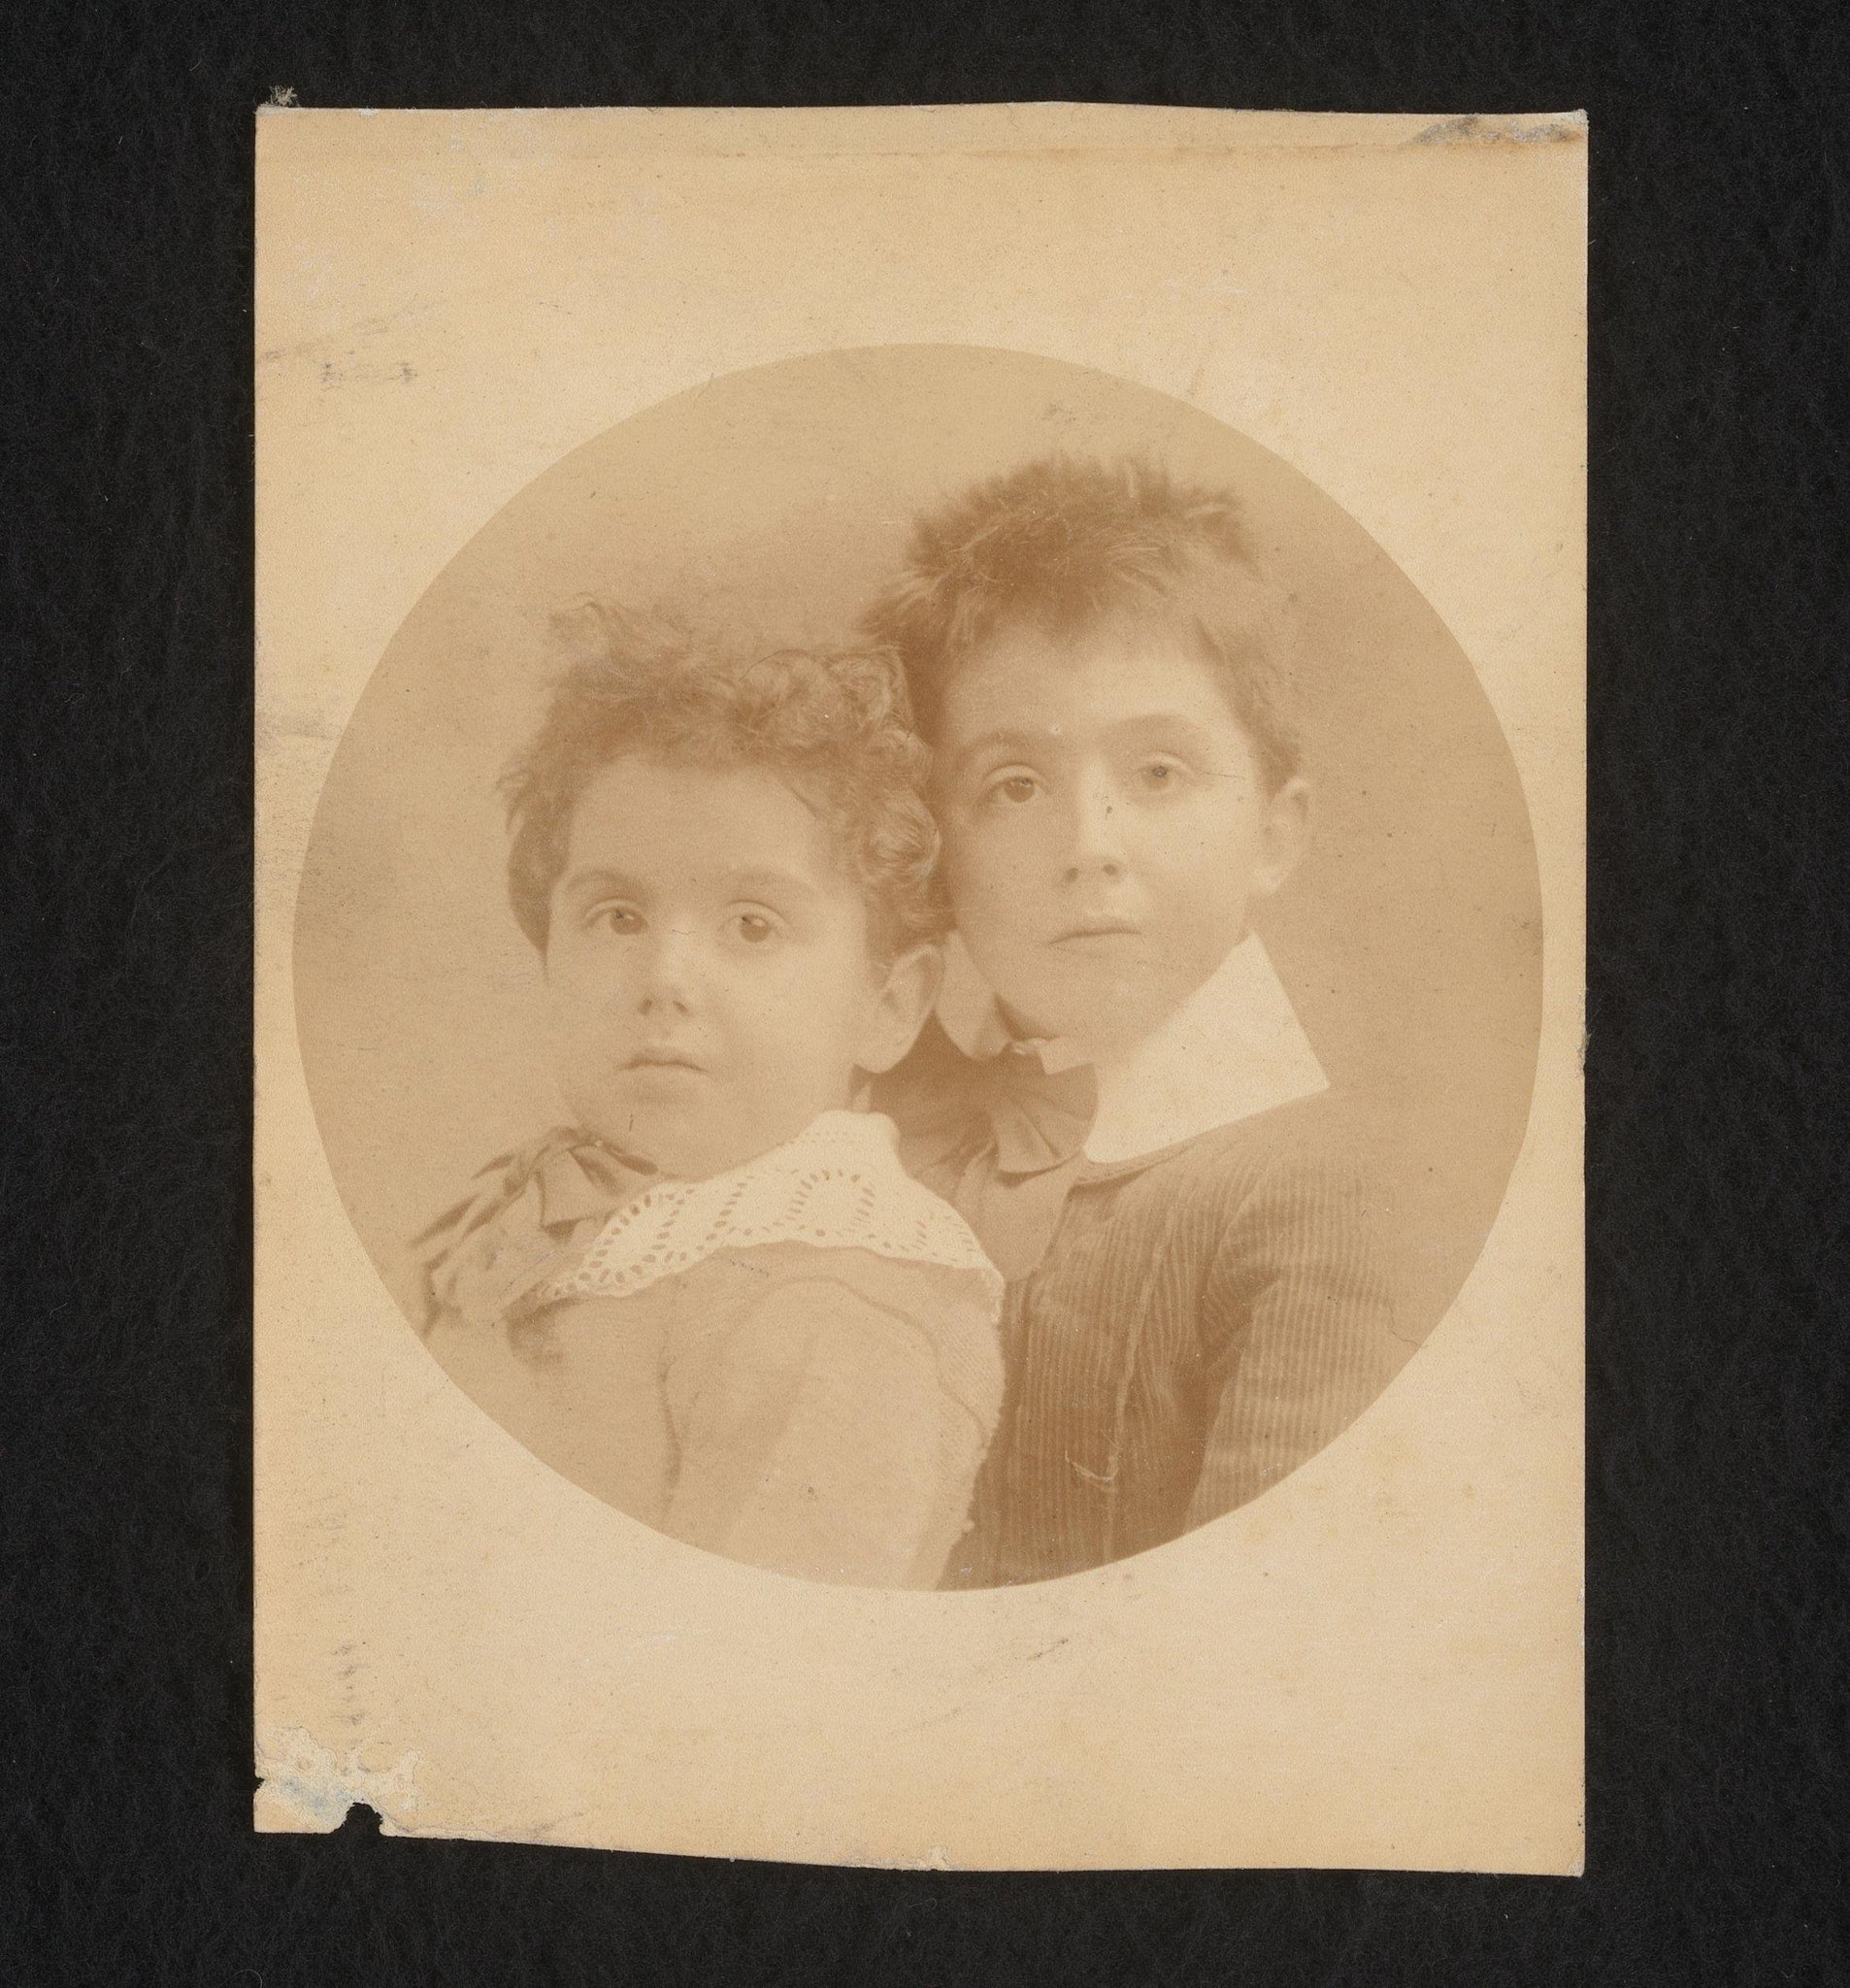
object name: photograph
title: Portret van twee jongens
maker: Anonymous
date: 1880-1920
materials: photographic support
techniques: collodion silver print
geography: netherlands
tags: boy (child between toddler and youth) (+ two persons), historical persons